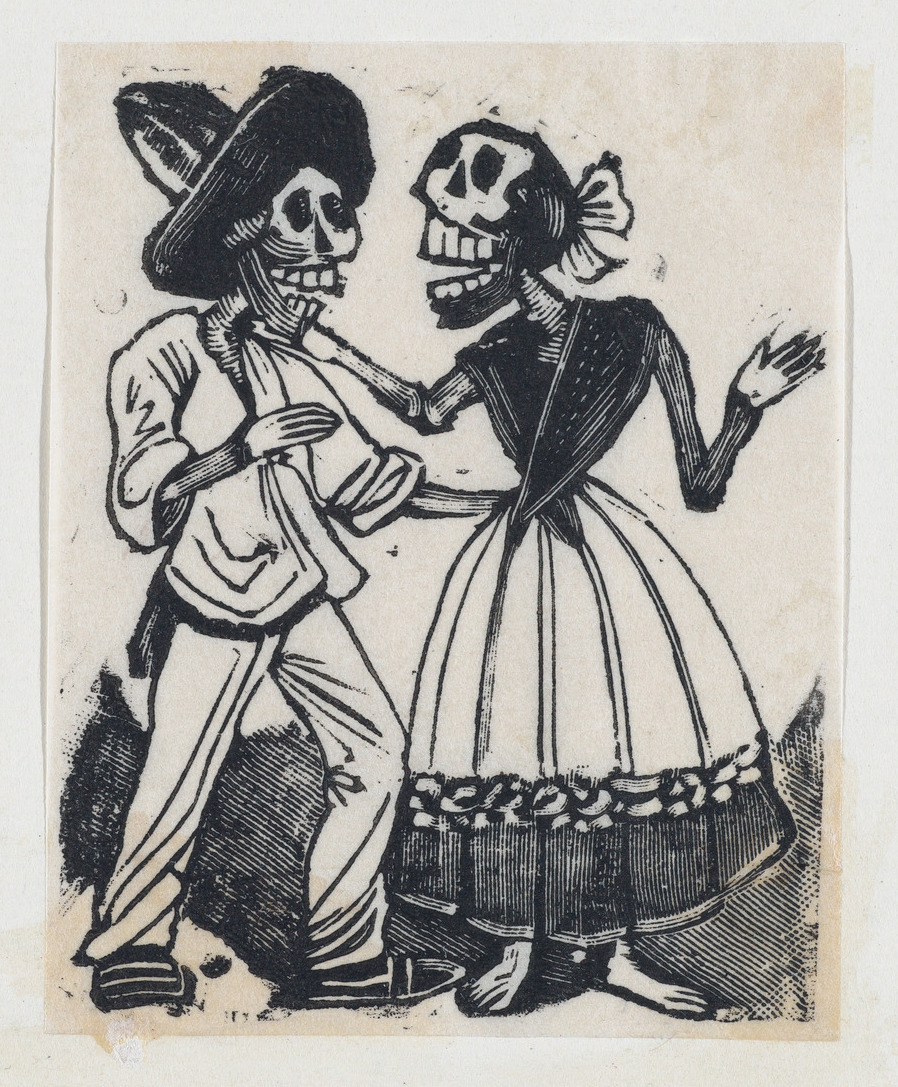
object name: print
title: Male and female skeleton talking (vignette for the feast of the dead)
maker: josé guadalupe posada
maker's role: artist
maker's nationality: mexican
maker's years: 1852-1913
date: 1890-1910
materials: metal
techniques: engraving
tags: skeletons,men,women